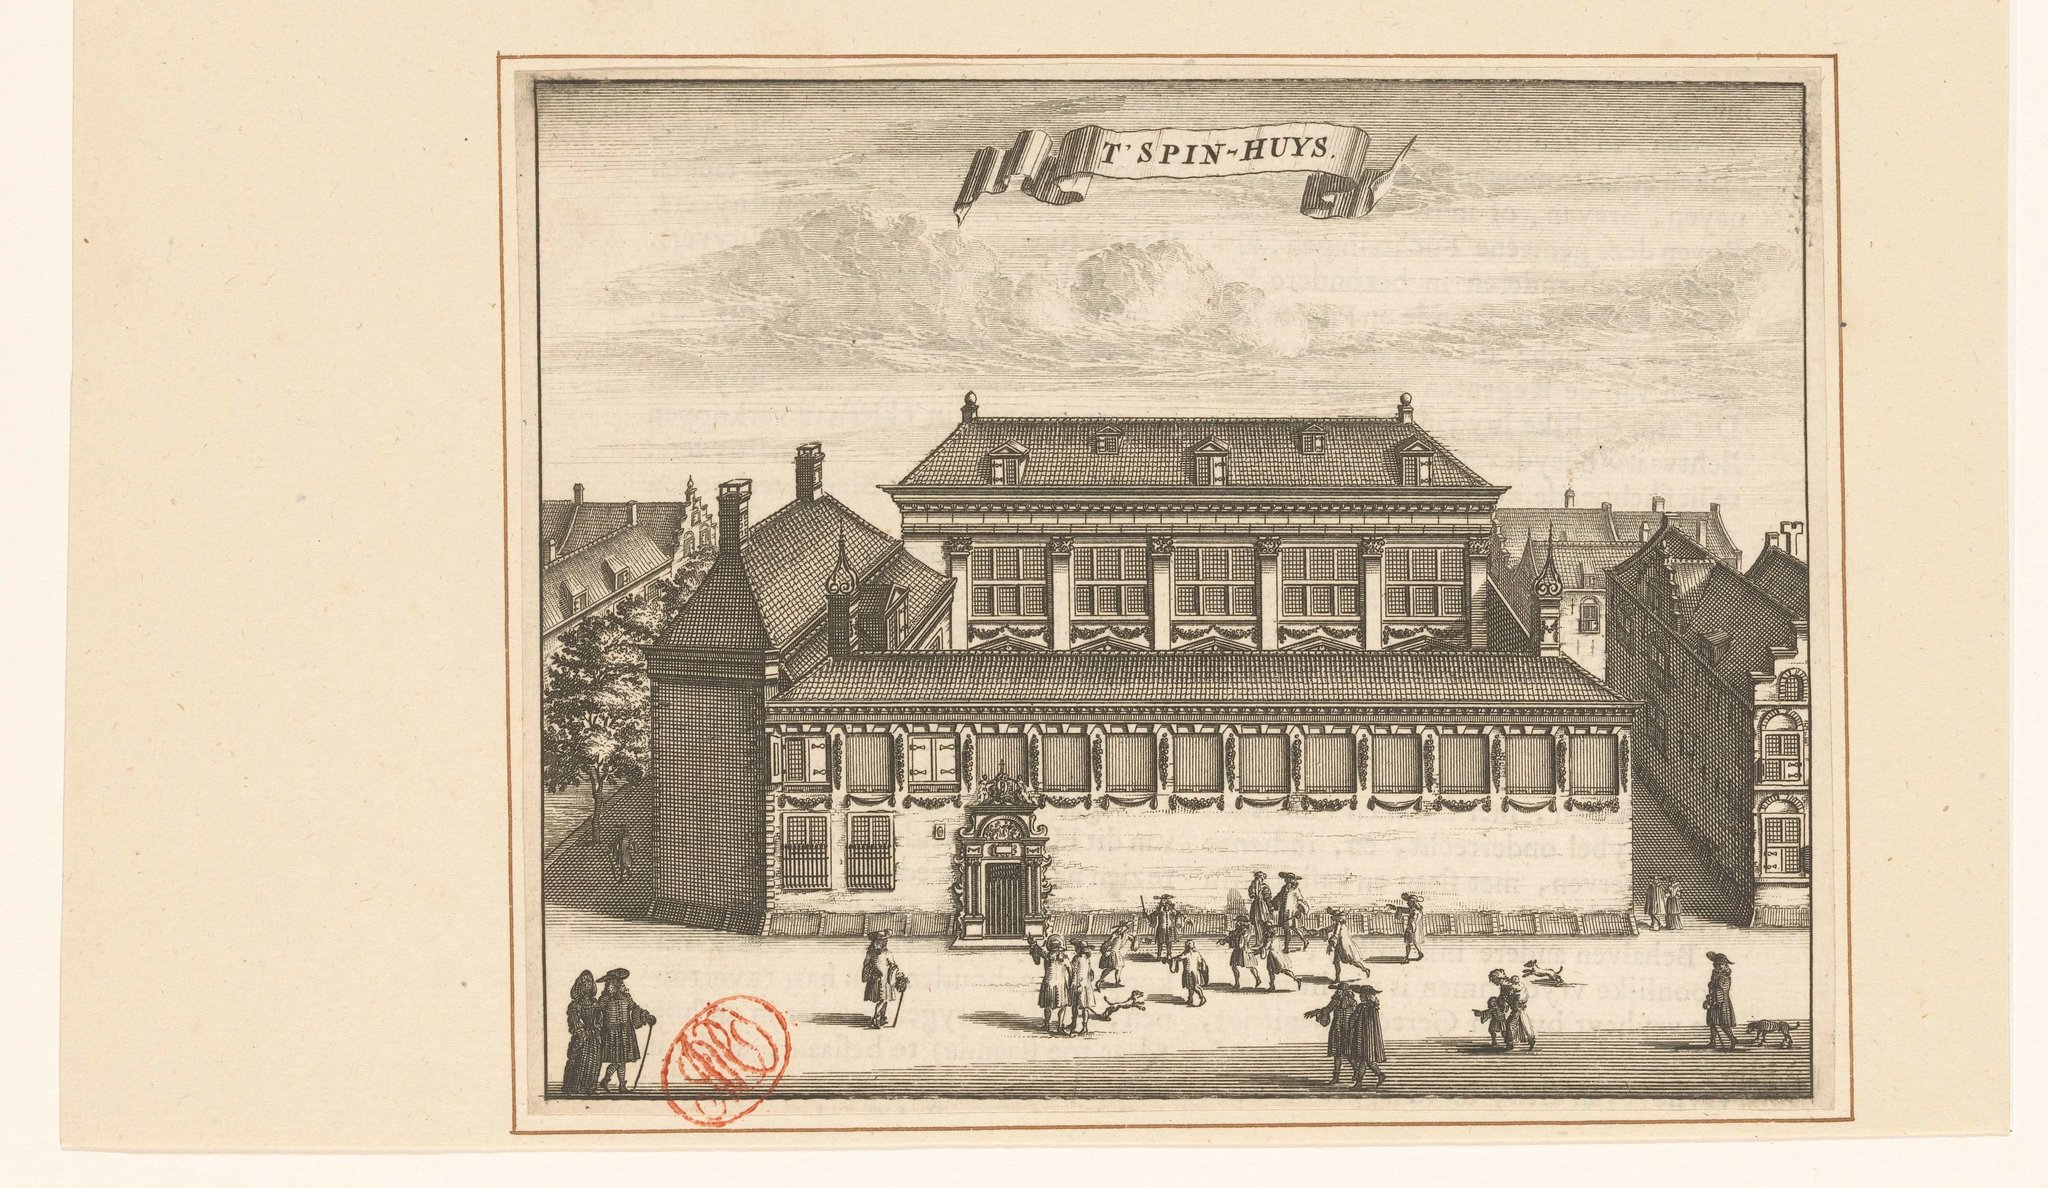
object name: print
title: Gezicht op het Spinhuis te Amsterdam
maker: Anonymous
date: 1693-1694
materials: paper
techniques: engraving, etching, letterpress printing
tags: prison, jail, gate, entrance, workhouse, penal camp, penitentiary, chain gang, street (+ city(-scape) with figures, staffage)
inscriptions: collector's mark: Lugt 195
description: Huidige staat van prent gebruikt in: Commelin, Caspar. Beschryvinge van Amsterdam, desselfs eerste oorspronk uyt den Huyse (…). 2 delen. Amsterdam: Abraham Wolfgang, Gillis Janssonius van Waesberge, Johannes Janssonius van Waesberge II, weduwe Dirk Boom I, Hendrick Boom en Rembertus Goethals, 1693. Of in: Commelin, Caspar. Beschryvinge van Amsterdam, zynde een naukeurige verhandelinge van desselfs eerste oorspronk uyt (…). 2 delen. Amsterdam: weduwe Aart Dircksz Oossaan, 1694. Latere staat ook gebruikt in: Commelin, Caspar. Beschryvinge van Amsterdam, zynde een naukeurige verhandelinge van desselfs eerste oorspronk uyt (…). 2 delen. 2e druk. Amsterdam: Andries van Damme, Johannes Ratelband, weduwe A. van Aaltwyk en Hermanus Uytwerf, 1726.